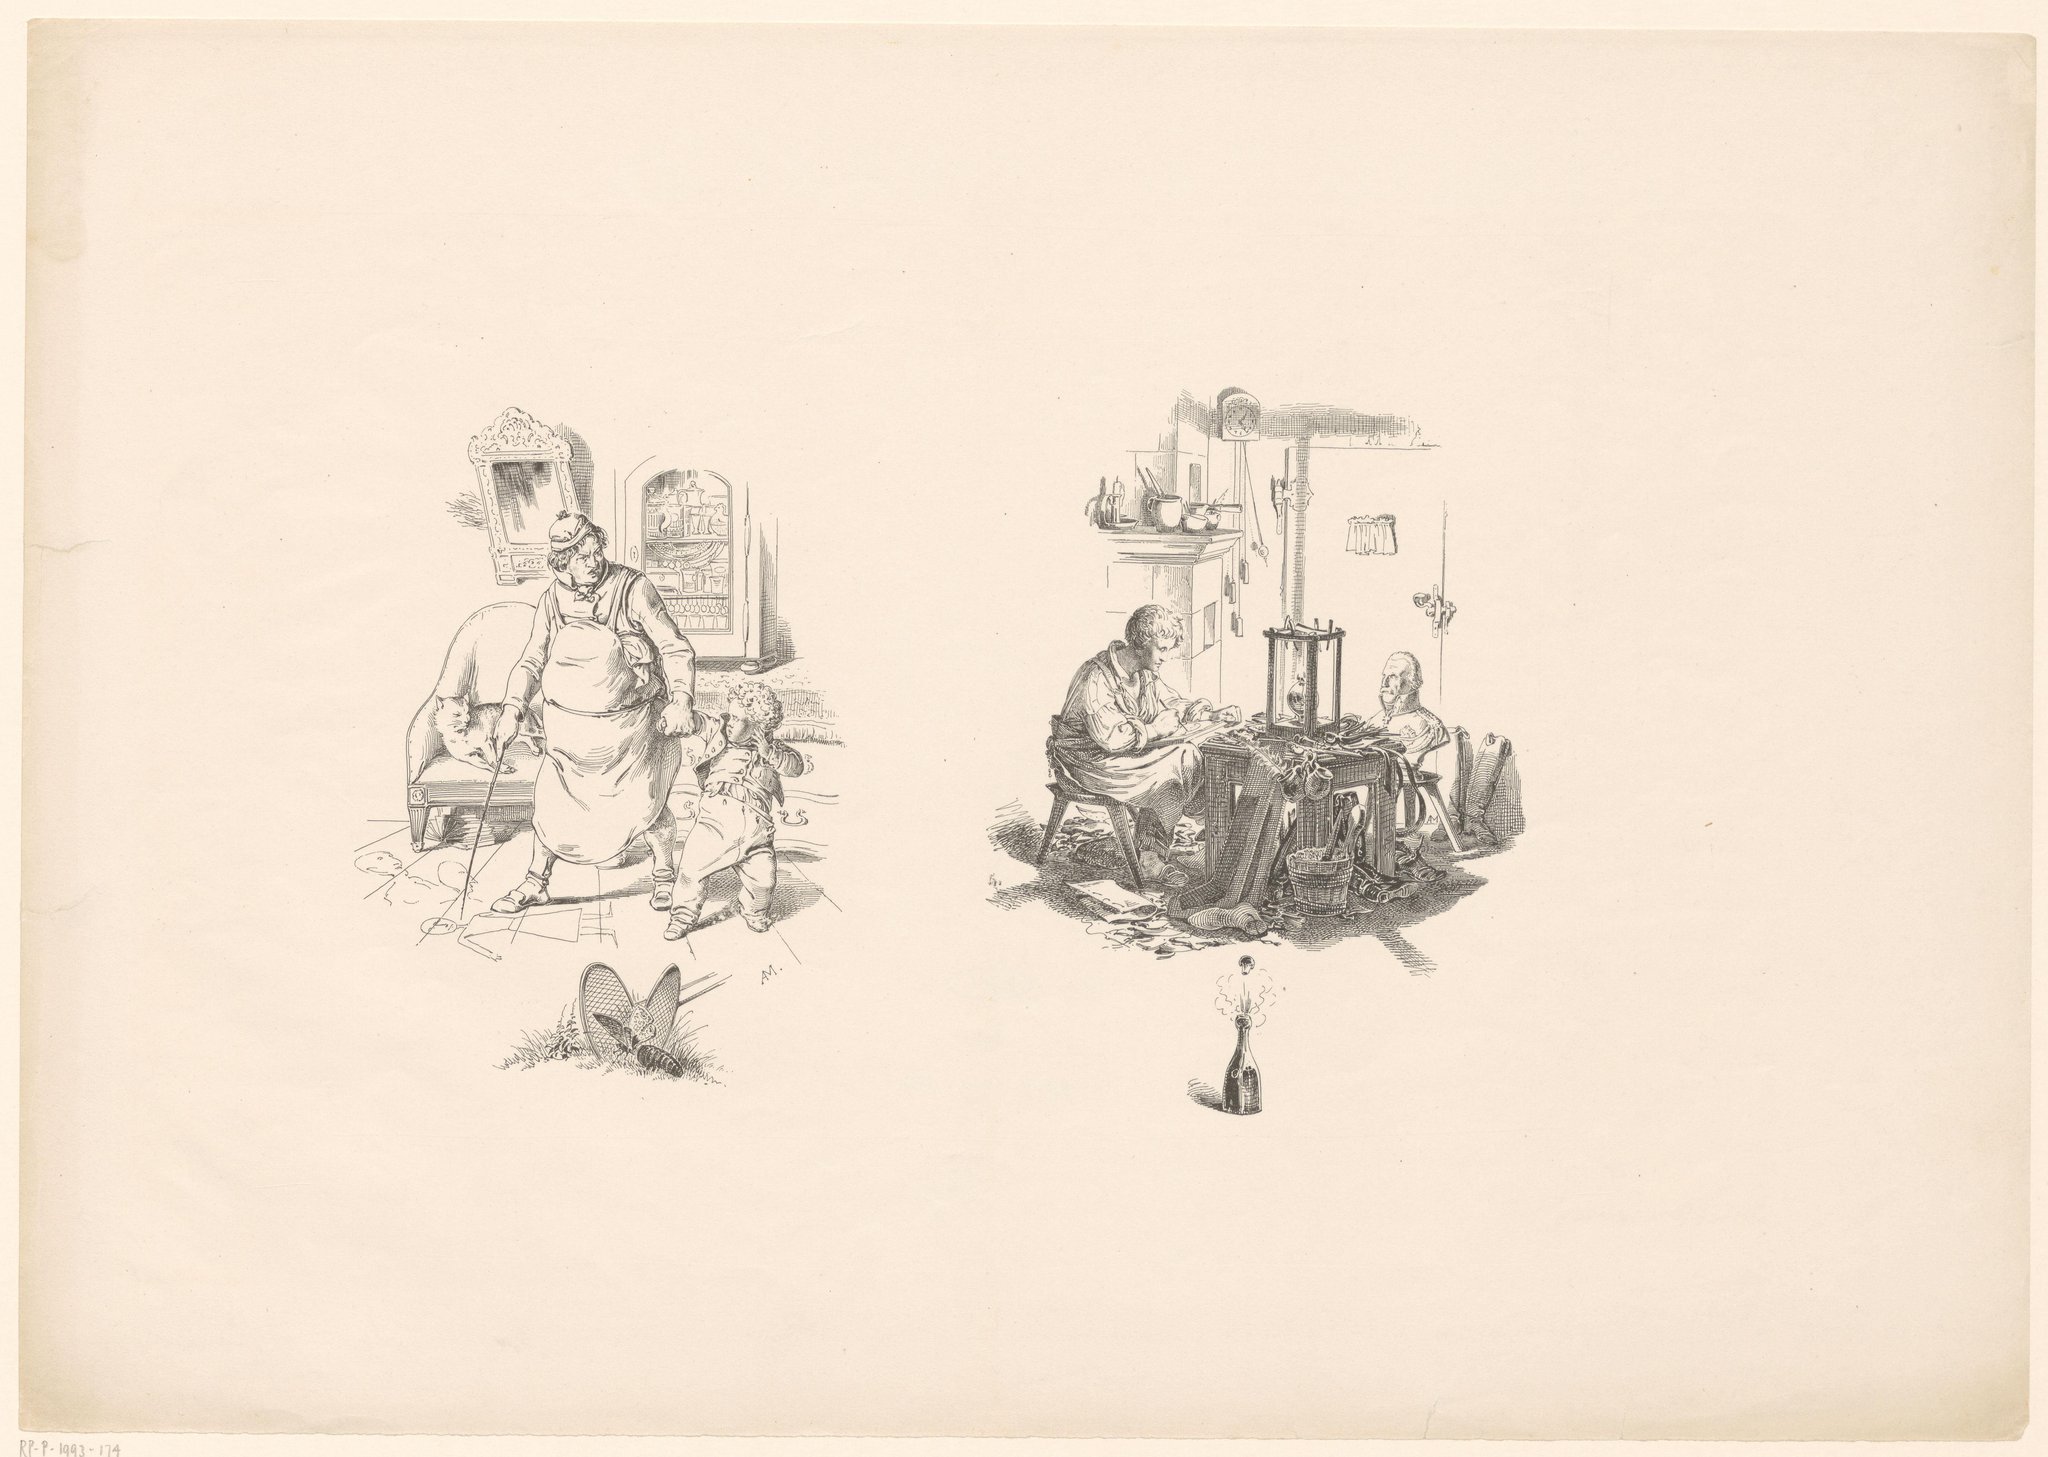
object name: print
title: Künstlers Erdenwallen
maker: adolph menzel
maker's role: draughtsman, painter, print maker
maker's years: 1815-1905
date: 1834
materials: paper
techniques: pen lithography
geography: berlin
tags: the artist and his family, relatives, etc., draughtsman at work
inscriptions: collector's mark: Lugt 2760, collector's mark: Lugt 2228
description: De kunstenaar wordt als kind gestraft voor tekenen op de vloer. Als tiener tekent hij 's nachts een buste na.